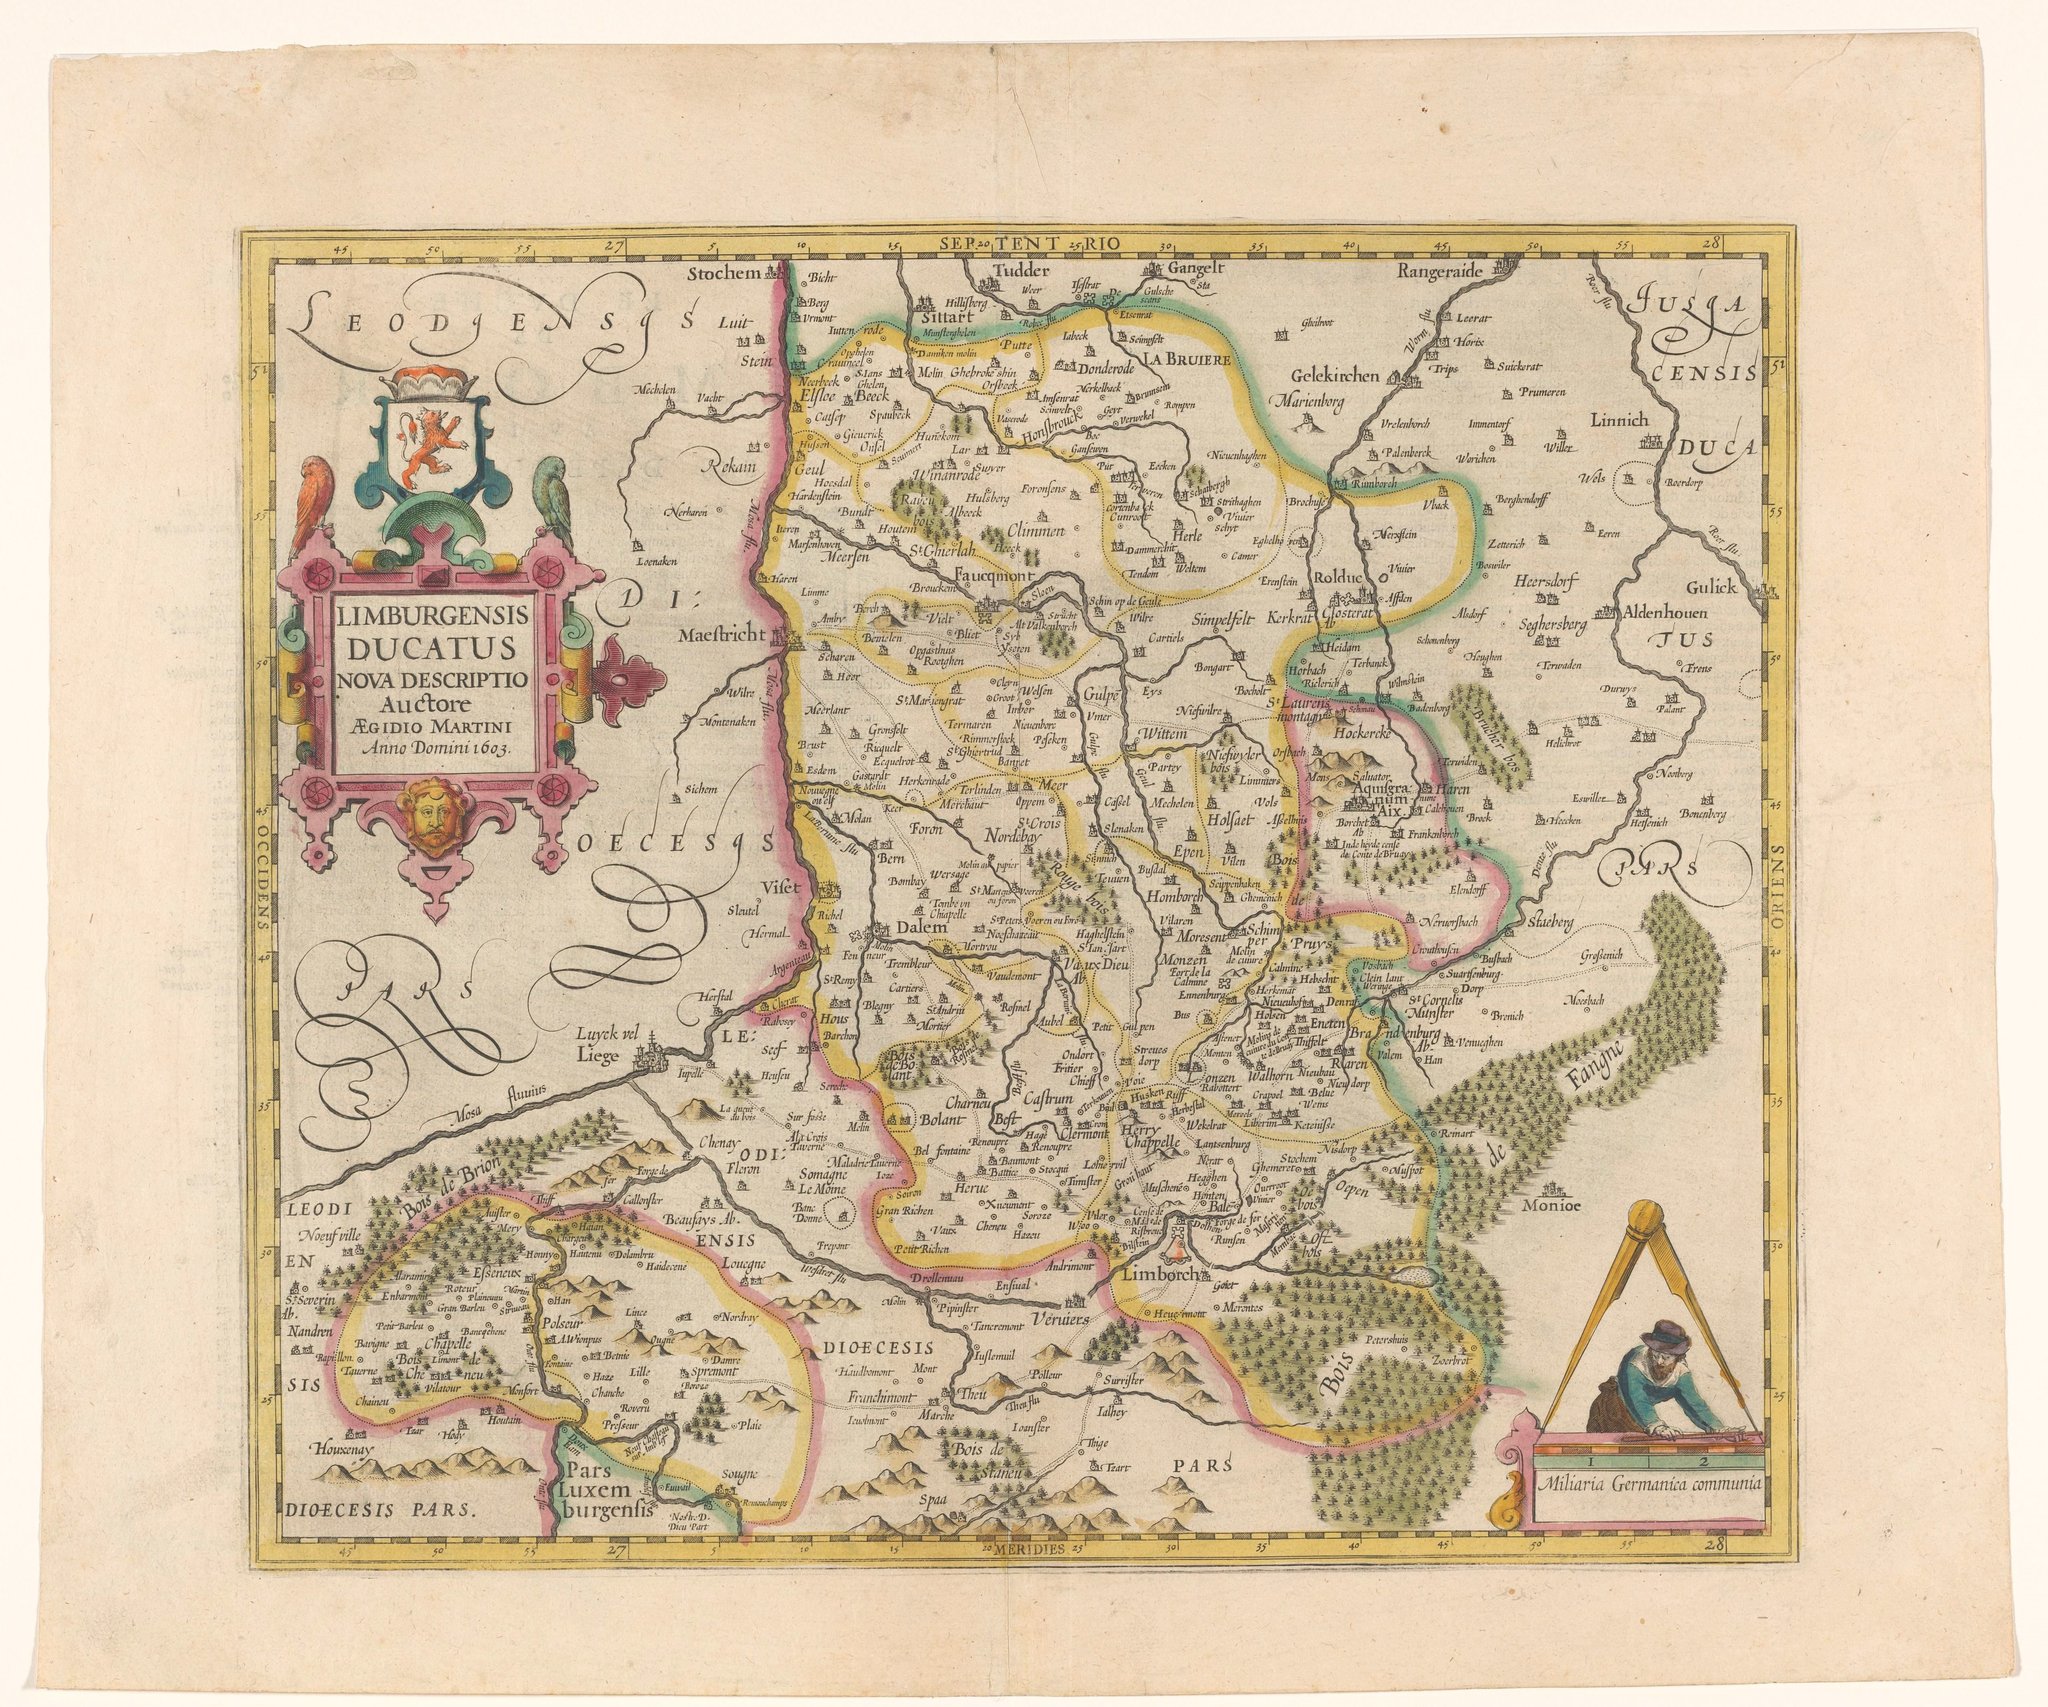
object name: map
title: Kaart van het hertogdom Limburg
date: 1628-1633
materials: paper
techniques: engraving, hand coloring, letterpress printing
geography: amsterdam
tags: maps of separate countries or regions, coat of arms (as symbol of the state, etc.) (+ province; provincial)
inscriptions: collector's mark: Lugt 2228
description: Prent gebruikt in: Mercator, Gerard en Jodocus Hondius. Altas sive cosmographicae meditationes de fabrica mundi (...). Amsterdam: Henricus Hondius, 1628. Of in: Mercator, Gerard en Jodocus Hondius. L'appendice de l'atlas de Gerard Mercator et Iudocus Hondius: contenant diverses nouvelles tables et descriptions (…). Amsterdam: Henricus Hondius, 1633.